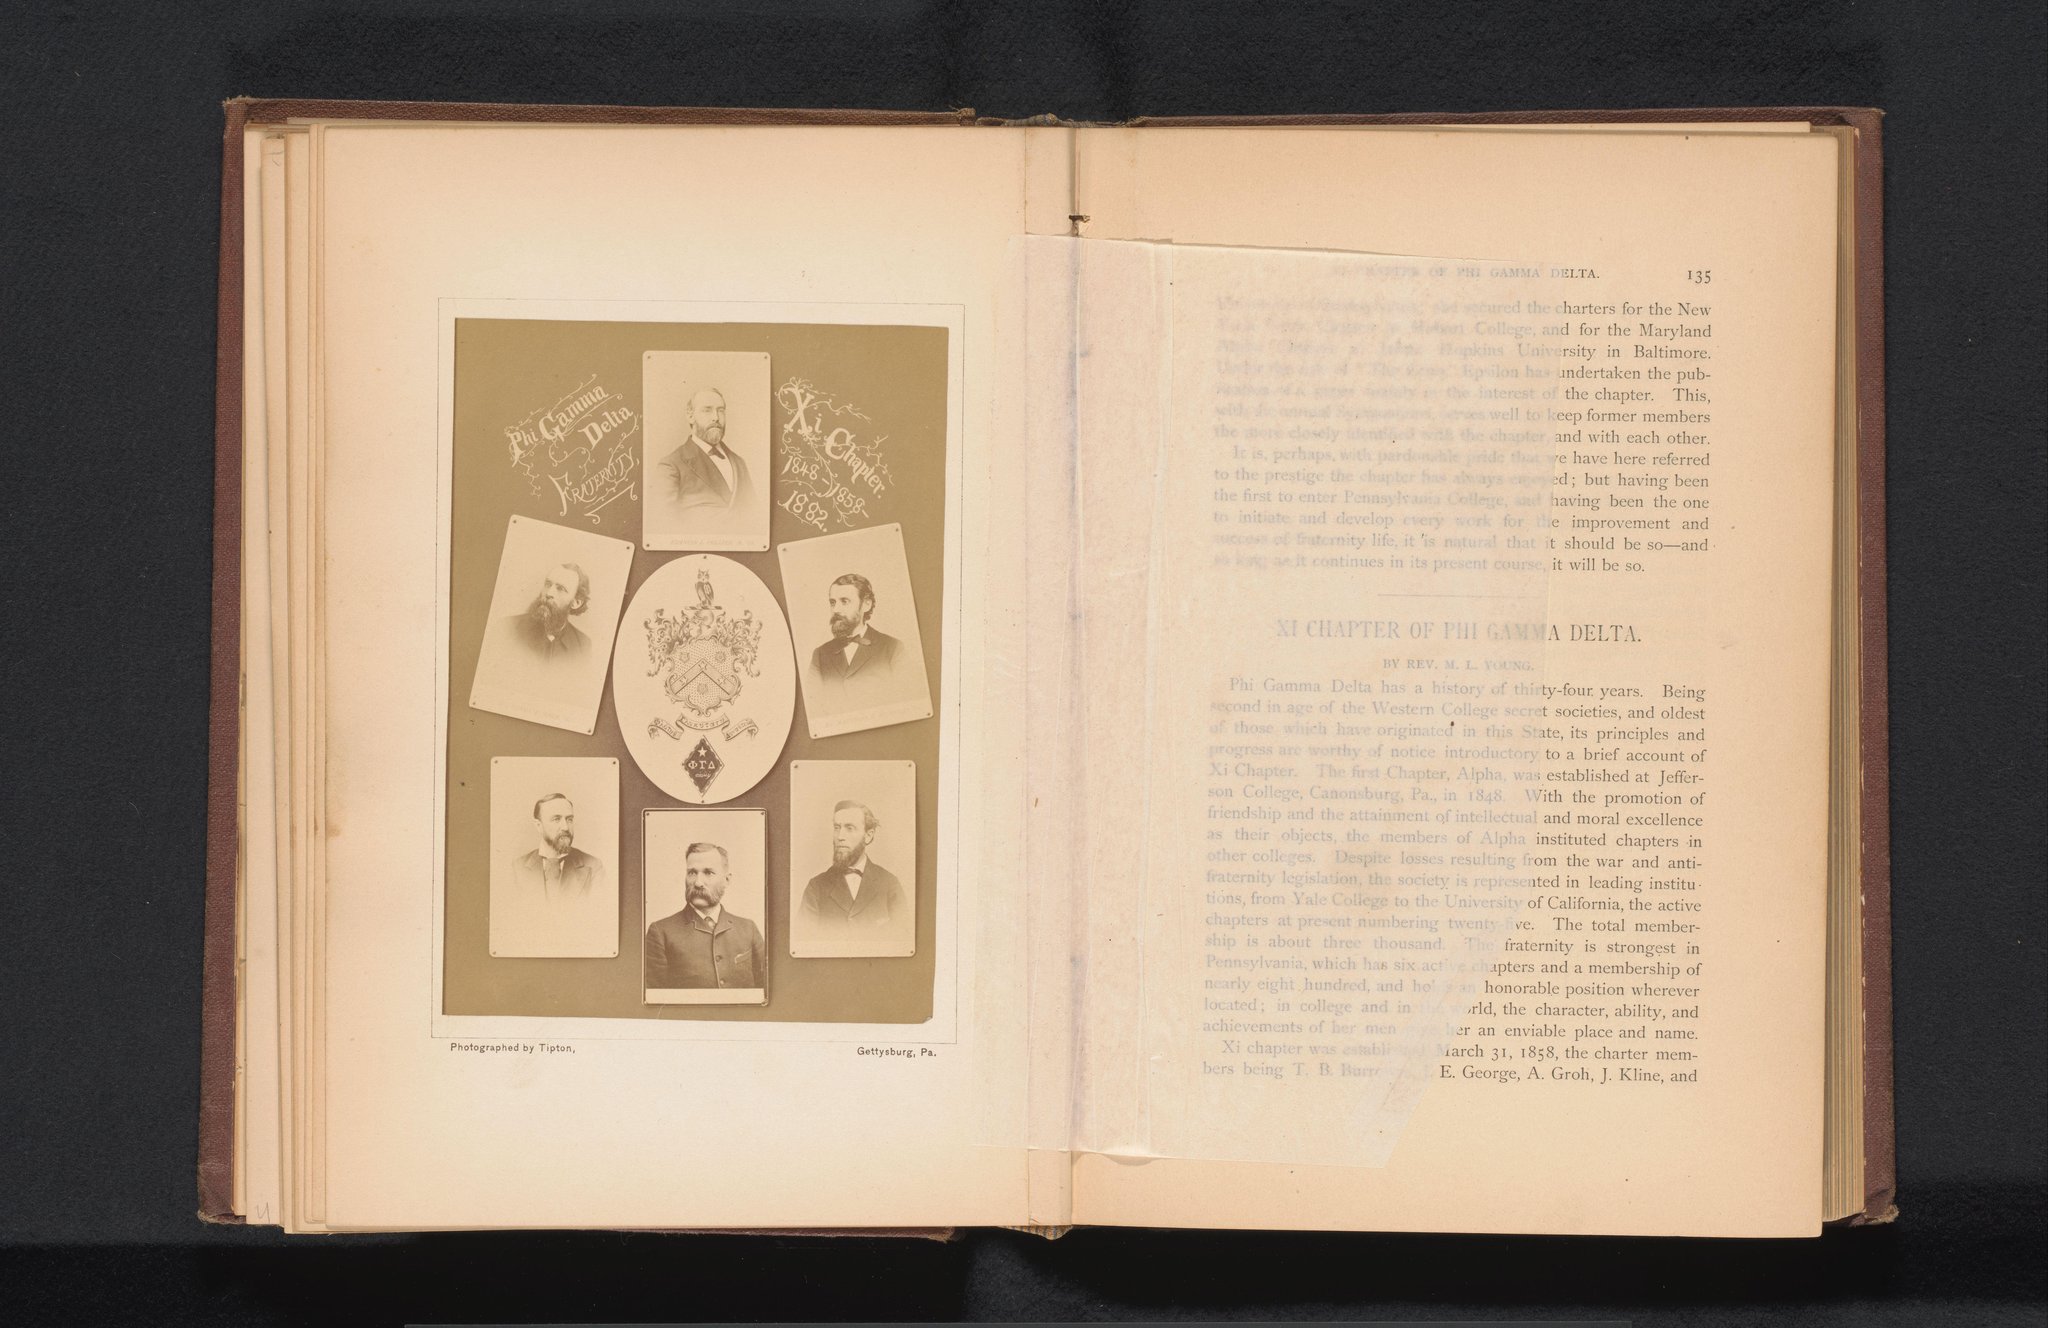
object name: photograph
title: Zes portretten van leden van het Phi-Gamma-Delta corps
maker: william h. tipton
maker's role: fotograaf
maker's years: 1850-1920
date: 1877-1882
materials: photographic support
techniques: albumen print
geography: gettysburg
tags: fraternity (students)